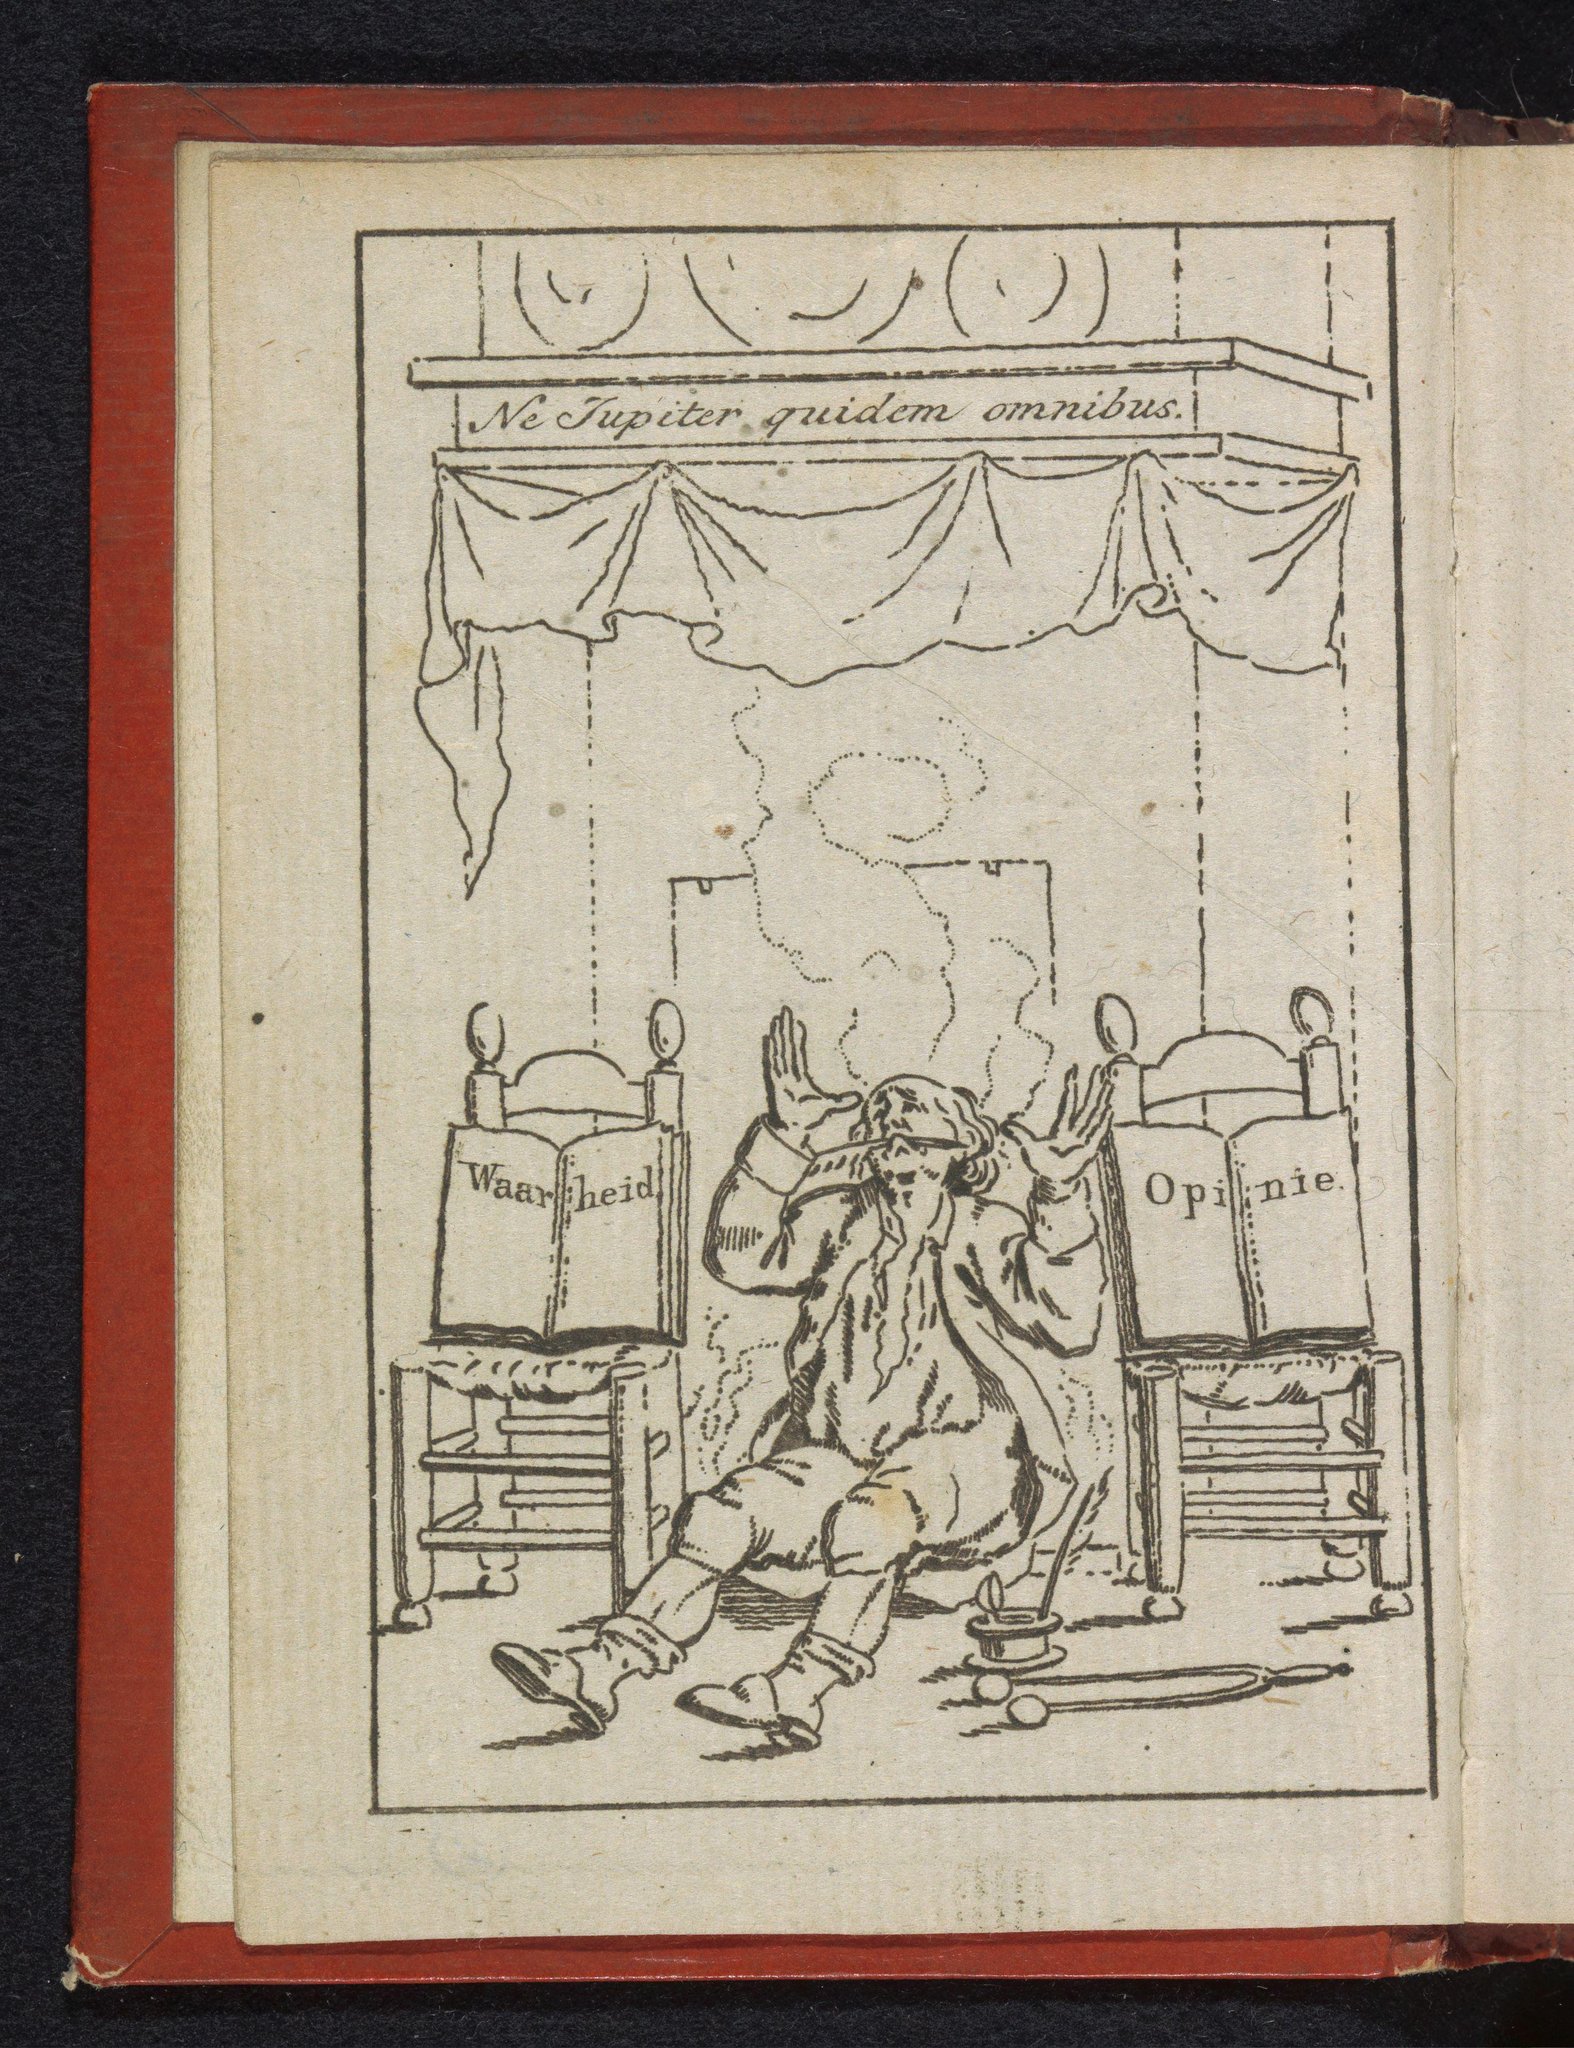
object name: print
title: Radeloze geschiedschrijver, 1796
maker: pieter van woensel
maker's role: print maker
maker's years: 1747-1808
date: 1795-1796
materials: paper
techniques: etching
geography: netherlands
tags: writer, poet, author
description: Spotprent van een schrijver die radeloos in de gloeiende as op de vloer zit voor de haard. Hij heft zijn handen in de lucht en houdt in zijn mond een schrijfveer. Aan weerszijden van hem twee boeken op stoelen: links de Waarheid, rechts de Opinie. Illustratie in Pieter van Woensels almanak 'De Lantaarn voor 1796'.